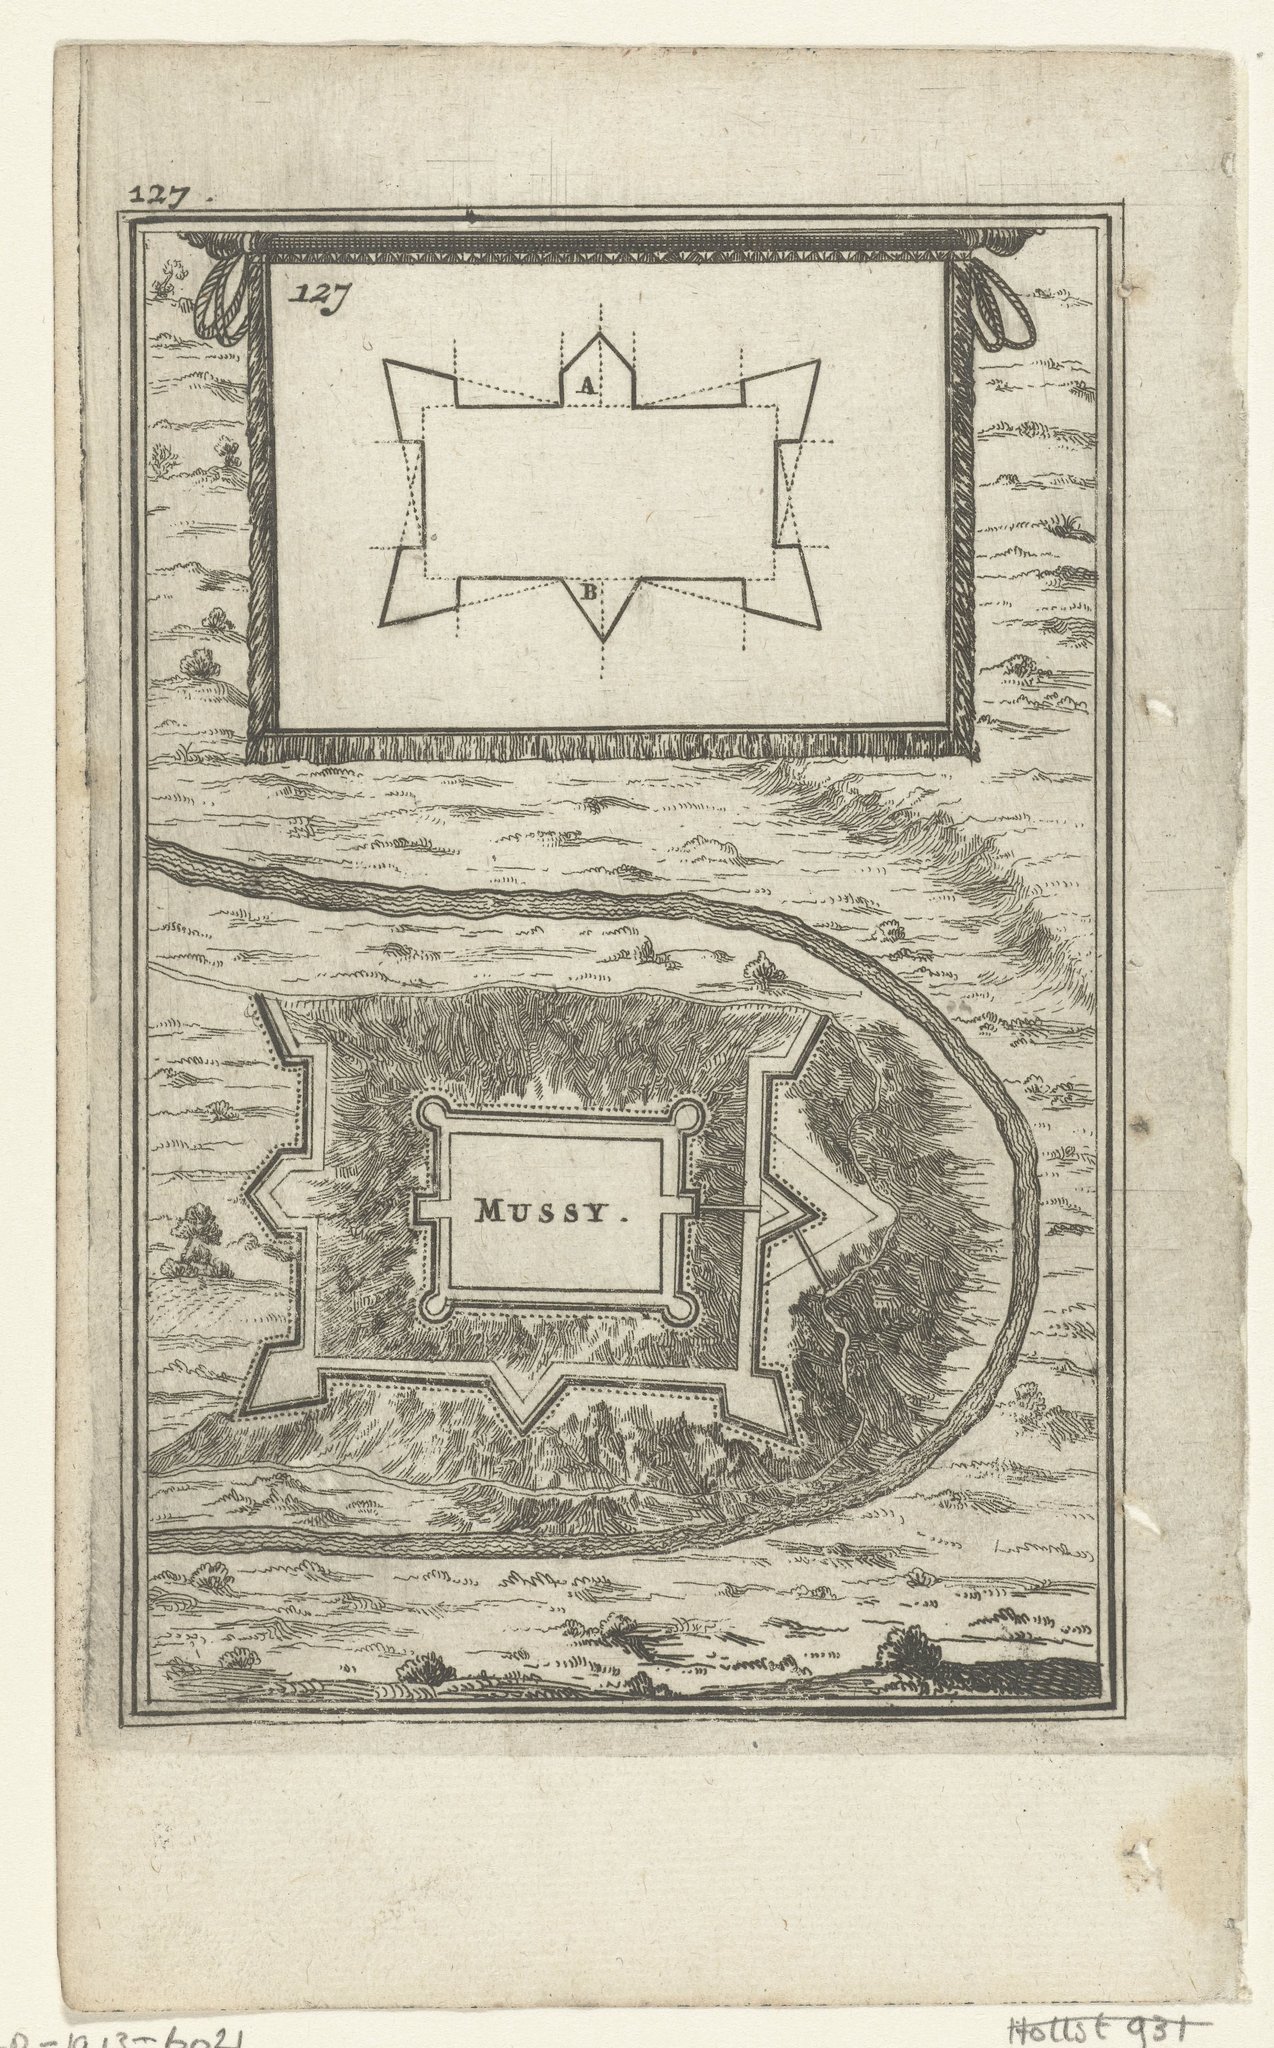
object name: book illustration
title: Illustratie voor 'Den Arbeid van Mars' van Allain Manesson Mallet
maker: romeyn de hooghe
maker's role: draughtsman, goldsmith, painter, print maker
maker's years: 1645-1708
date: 1672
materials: paper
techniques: etching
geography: amsterdam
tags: city-view in general; 'veduta', river, fortifications, military engineering, france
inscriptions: collector's mark: Lugt 2228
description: Grondplan van een vesting aan een rivier ('Mussy' = Mussy-sur-Seine?). Daarboven, als op een doek, een gezicht op de betreffende stad. In de hoek linksboven tweemaal het cijfer 127 (= het nummer van de pagina in het boek waartegenover de illustratie geplaatst is).